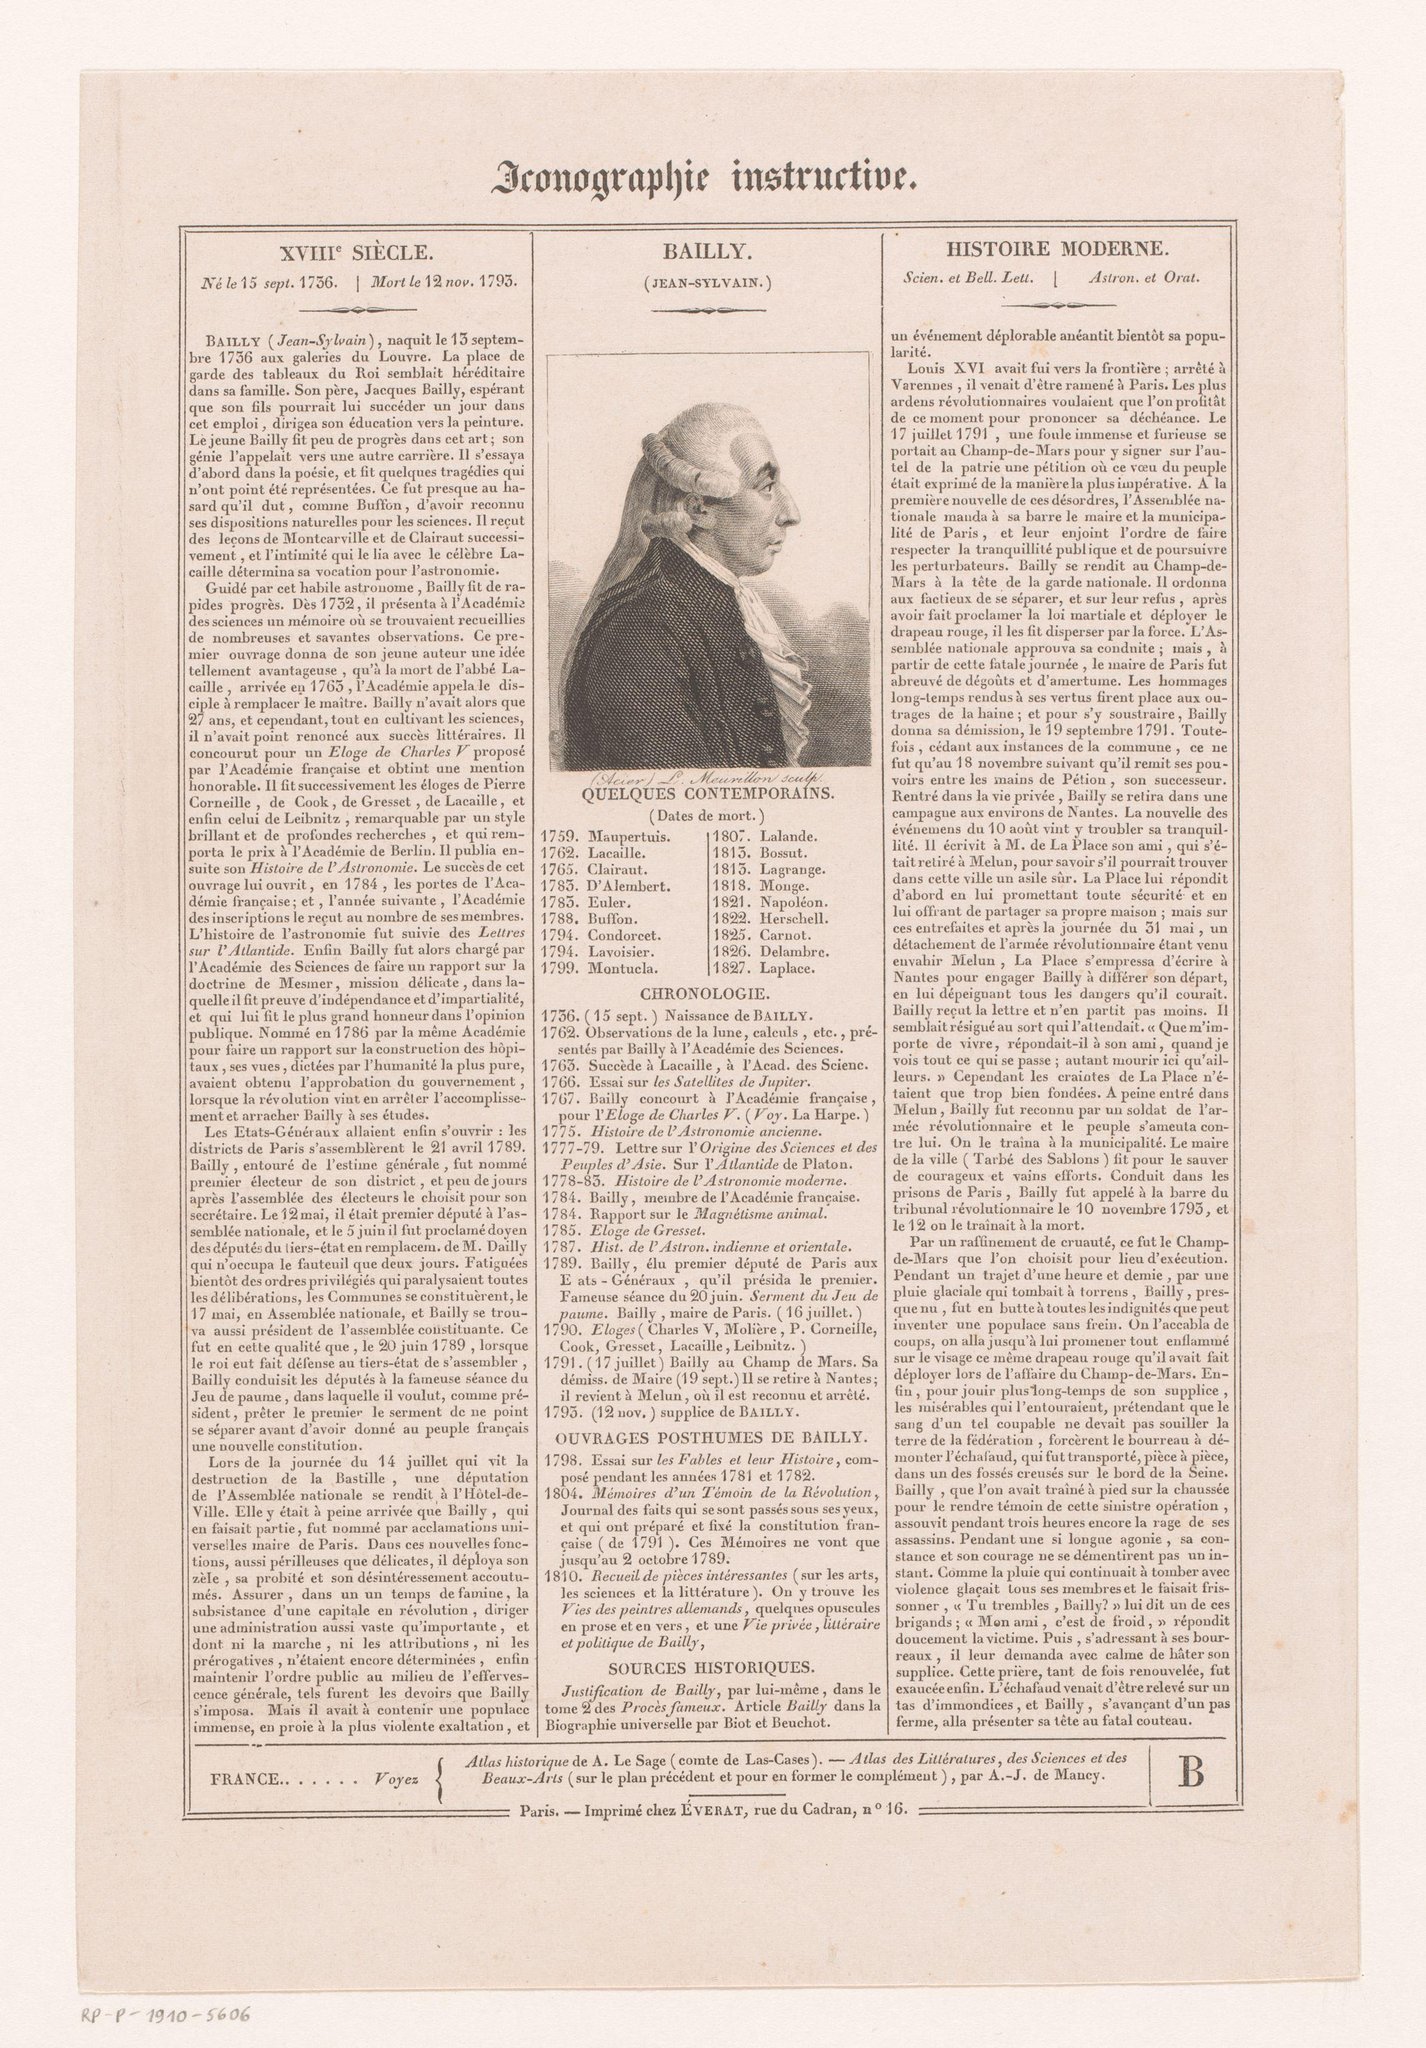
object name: print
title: Portret van Jean Sylvain Bailly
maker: l. meurillon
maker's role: print maker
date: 1800-1899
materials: paper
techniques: letterpress printing, engraving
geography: paris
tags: paris, politician, mayor, historical persons, politician, e.g. party leader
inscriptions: collector's mark: Lugt 2228